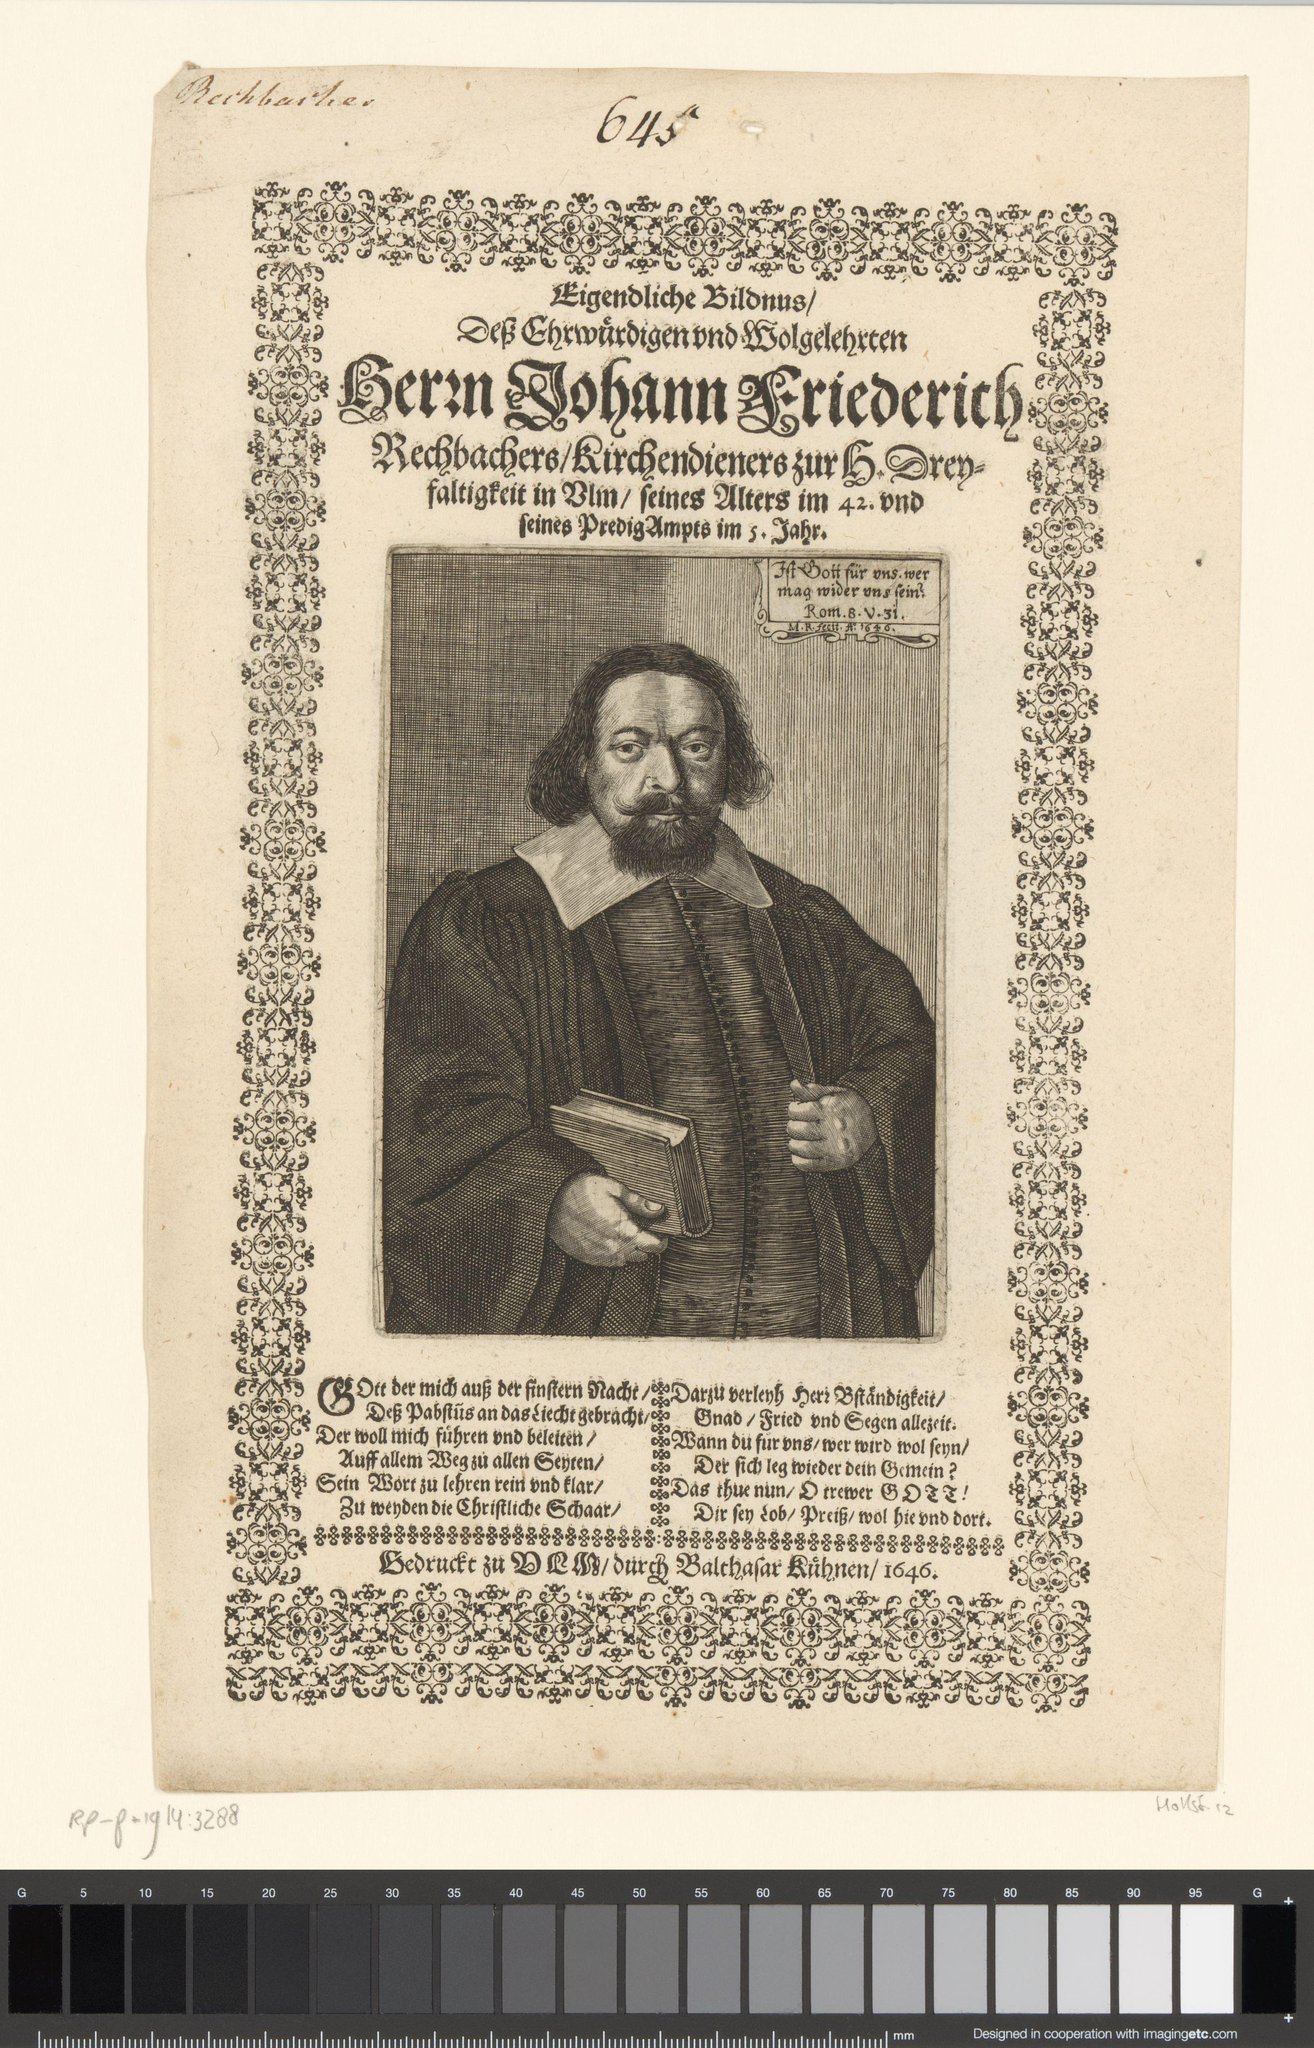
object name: print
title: Portret van Johann Friedrich Rechbacher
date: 1646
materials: paper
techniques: engraving, letterpress printing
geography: ulm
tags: historical persons, book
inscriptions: collector's mark: Lugt 2228